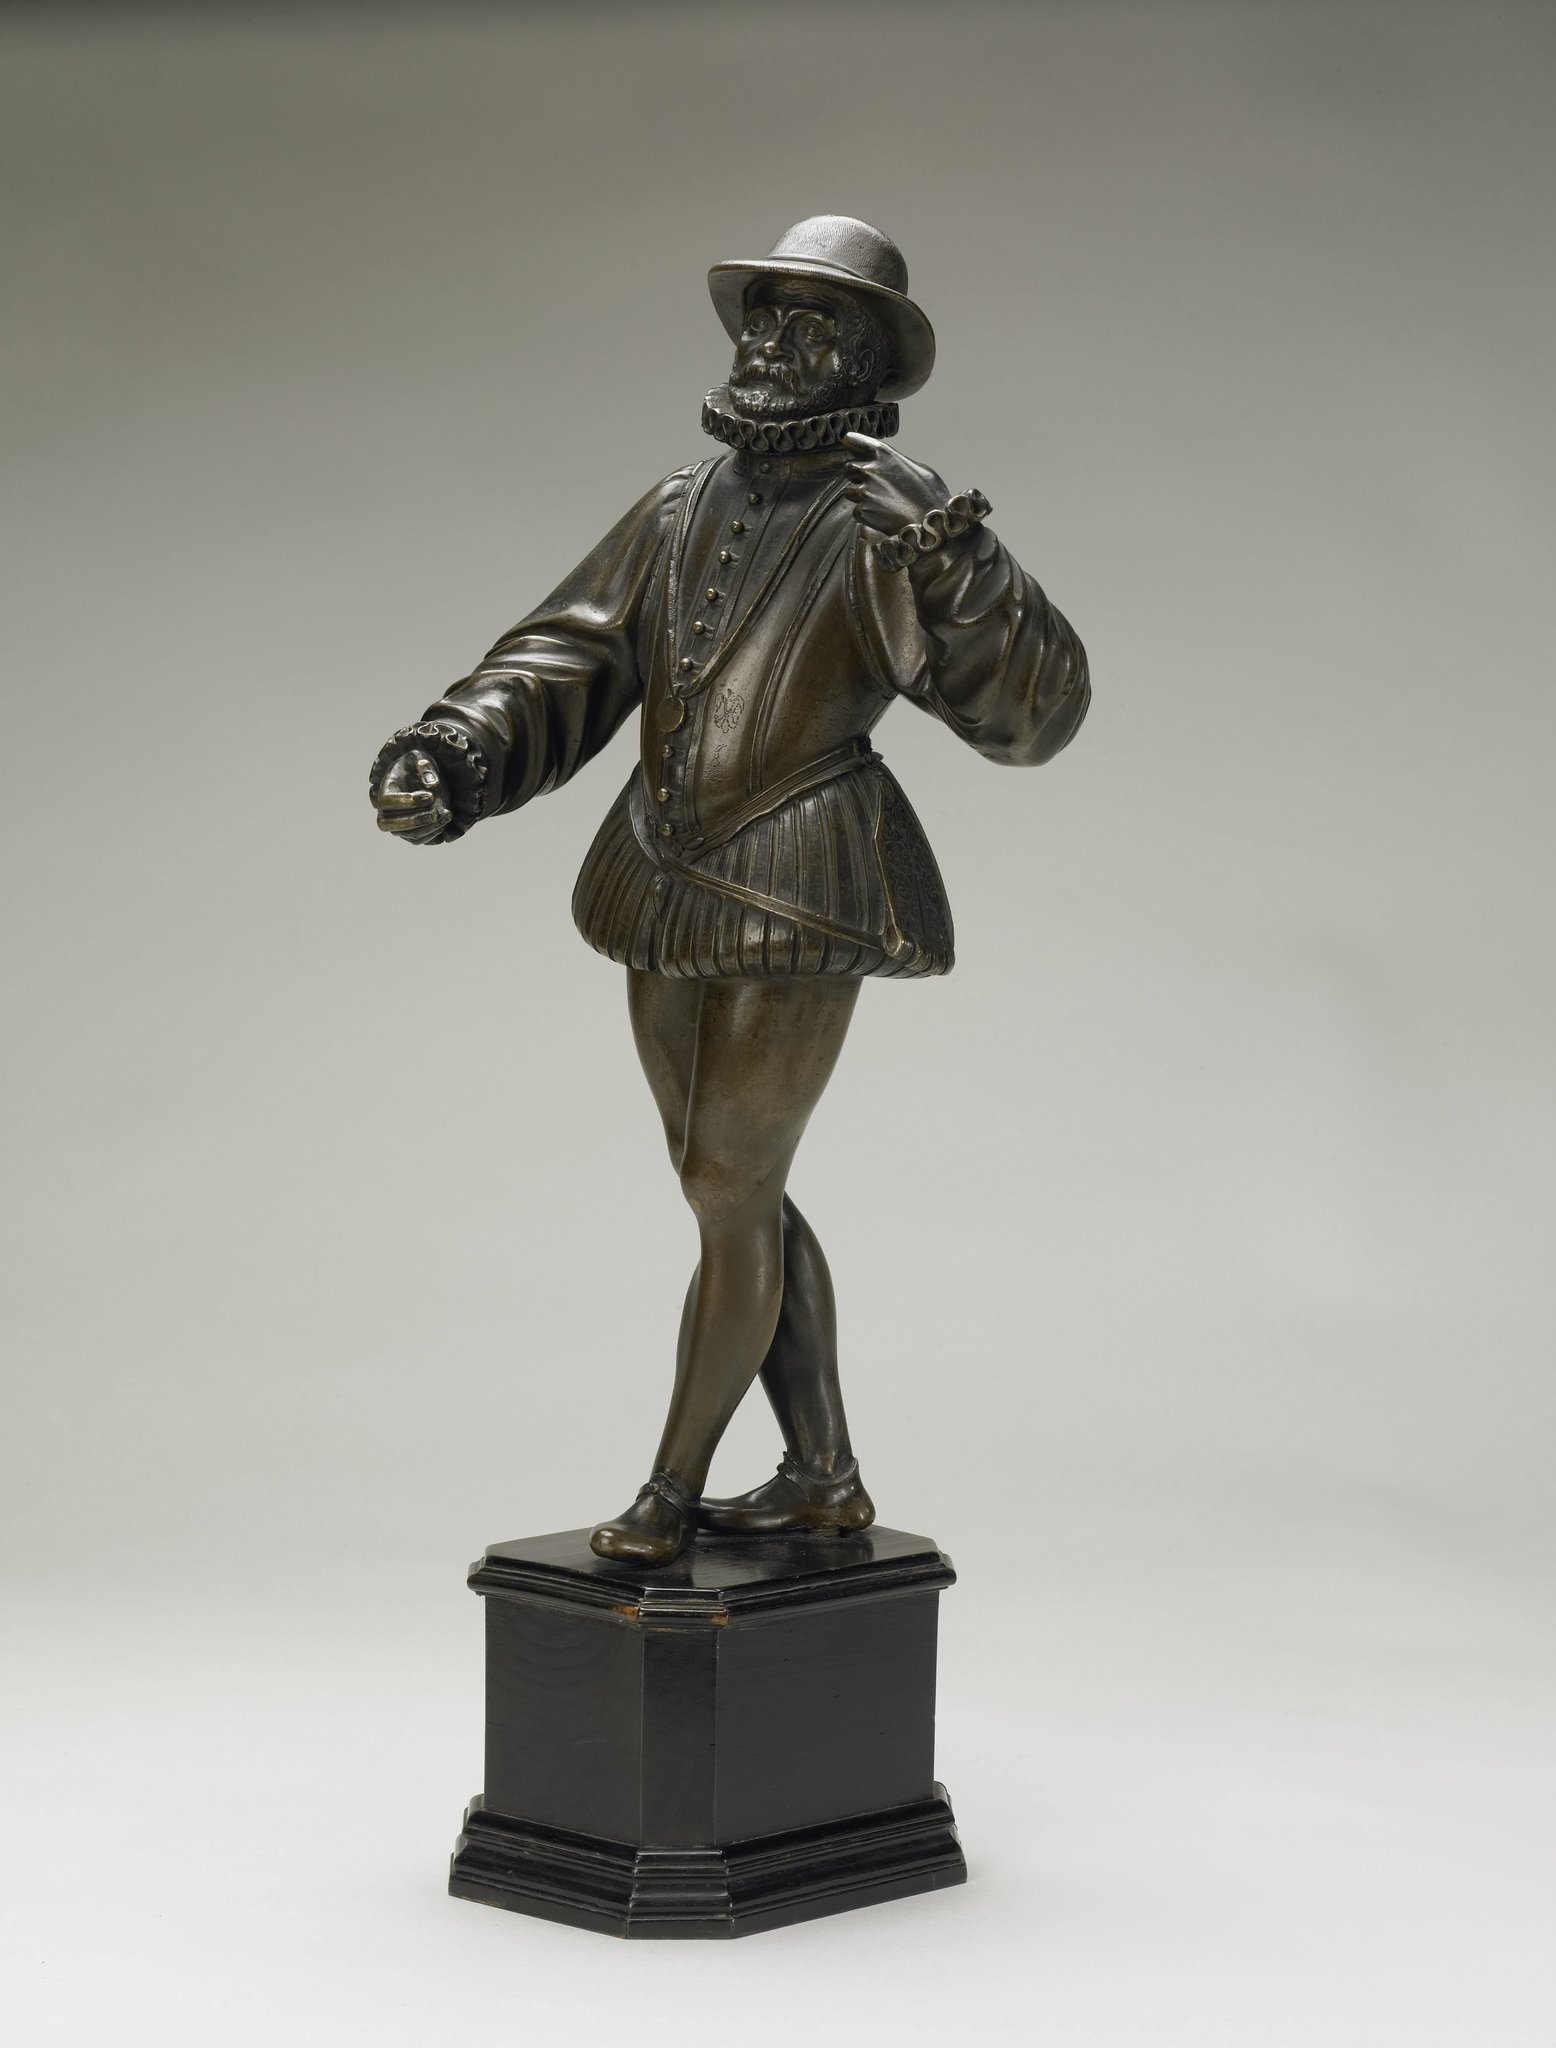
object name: sculpture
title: Man Walking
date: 1600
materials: bronze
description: The limbs of this figure of a walking man were cast individually and assembled later. It was probably originally intended as part of a clock or an automaton, which would have had a mechanism to move its arms and legs. Such moving objects were prized possessions and found their way to princely Kunstkammern (cabinets of art and curiosities) throughout Europe.